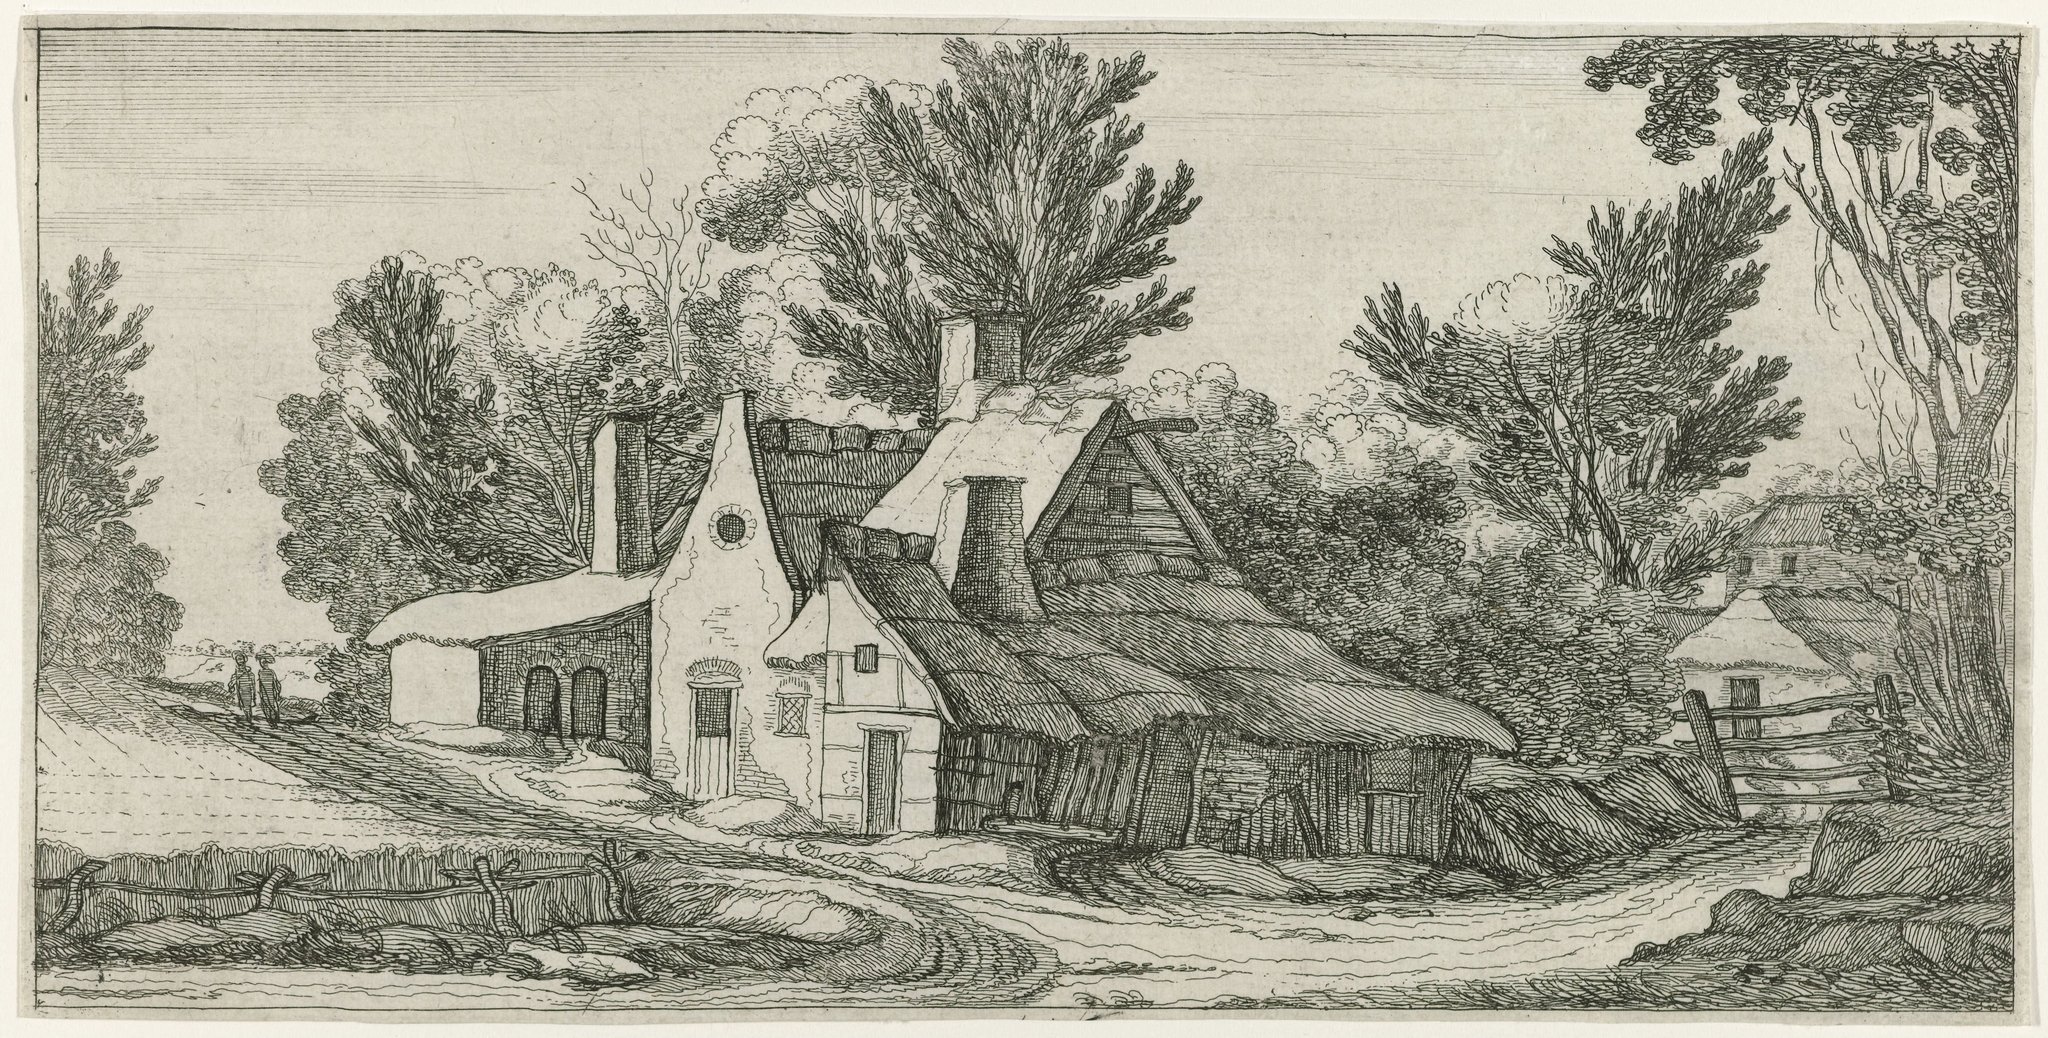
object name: print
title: Landschap met boerderijen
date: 1625-1661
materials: paper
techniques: etching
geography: lyon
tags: farm (building)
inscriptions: collector's mark: Lugt 2228, collector's mark: Lugt 2760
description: De prent maakt deel uit van serie van veertien waarvan één bij Franken-Van der Kellen is opgenomen onder 'Piéces douteuses'. Hollstein ïdentificeert de reeks uitgegeven door Barthélemy Gaultier en Claude Savary (vergelijk Inventaire Fonds Francais XVIIe eeuw, dl. 4, pp. 414-415 waar reeks overigens niet is beschreven). Een complete reeks bevond zich in 1989 bij Kunsthandel Th. Laurentius, Voorschoten.